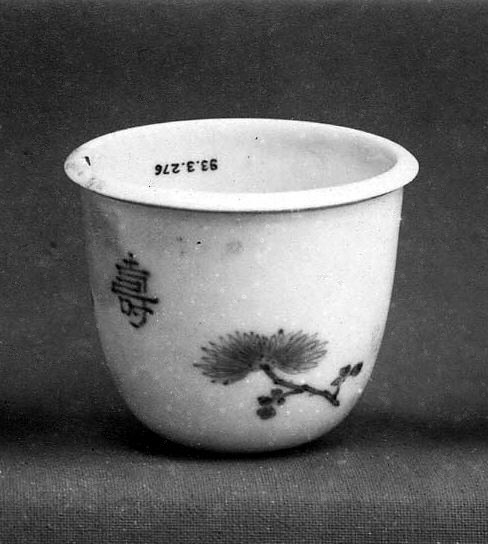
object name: wine cup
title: Nesting Wine Cup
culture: japanese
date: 1820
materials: glaze, porcelain